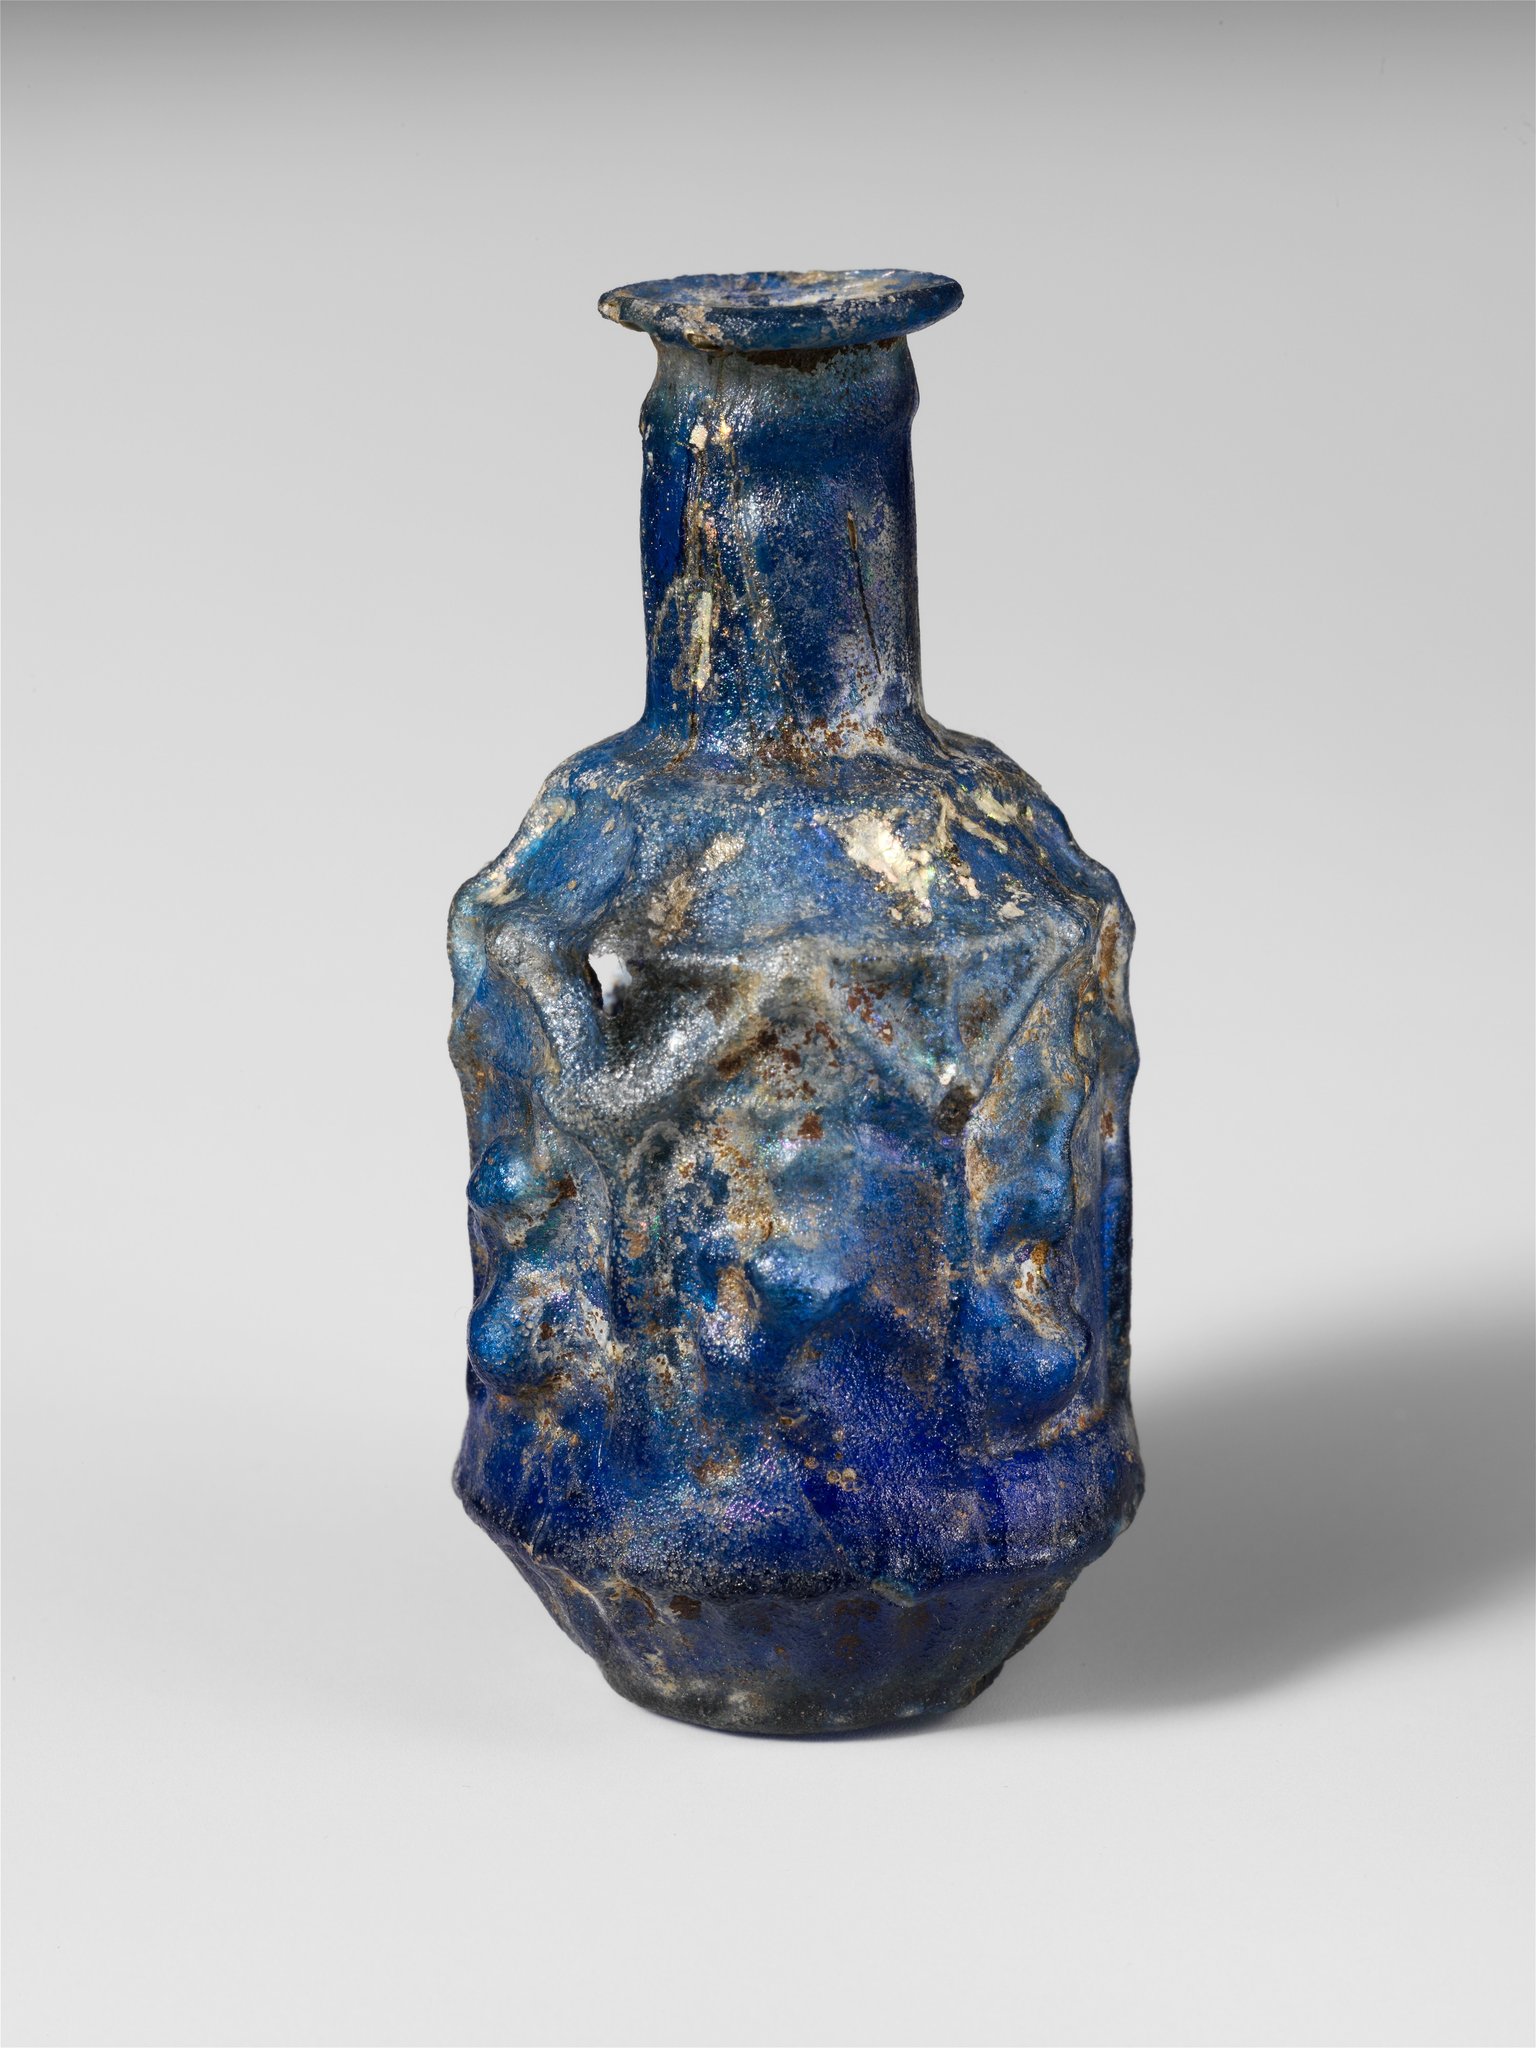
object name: bottle, hexagonal, with bird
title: Glass hexagonal bottle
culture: roman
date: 25-50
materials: glass